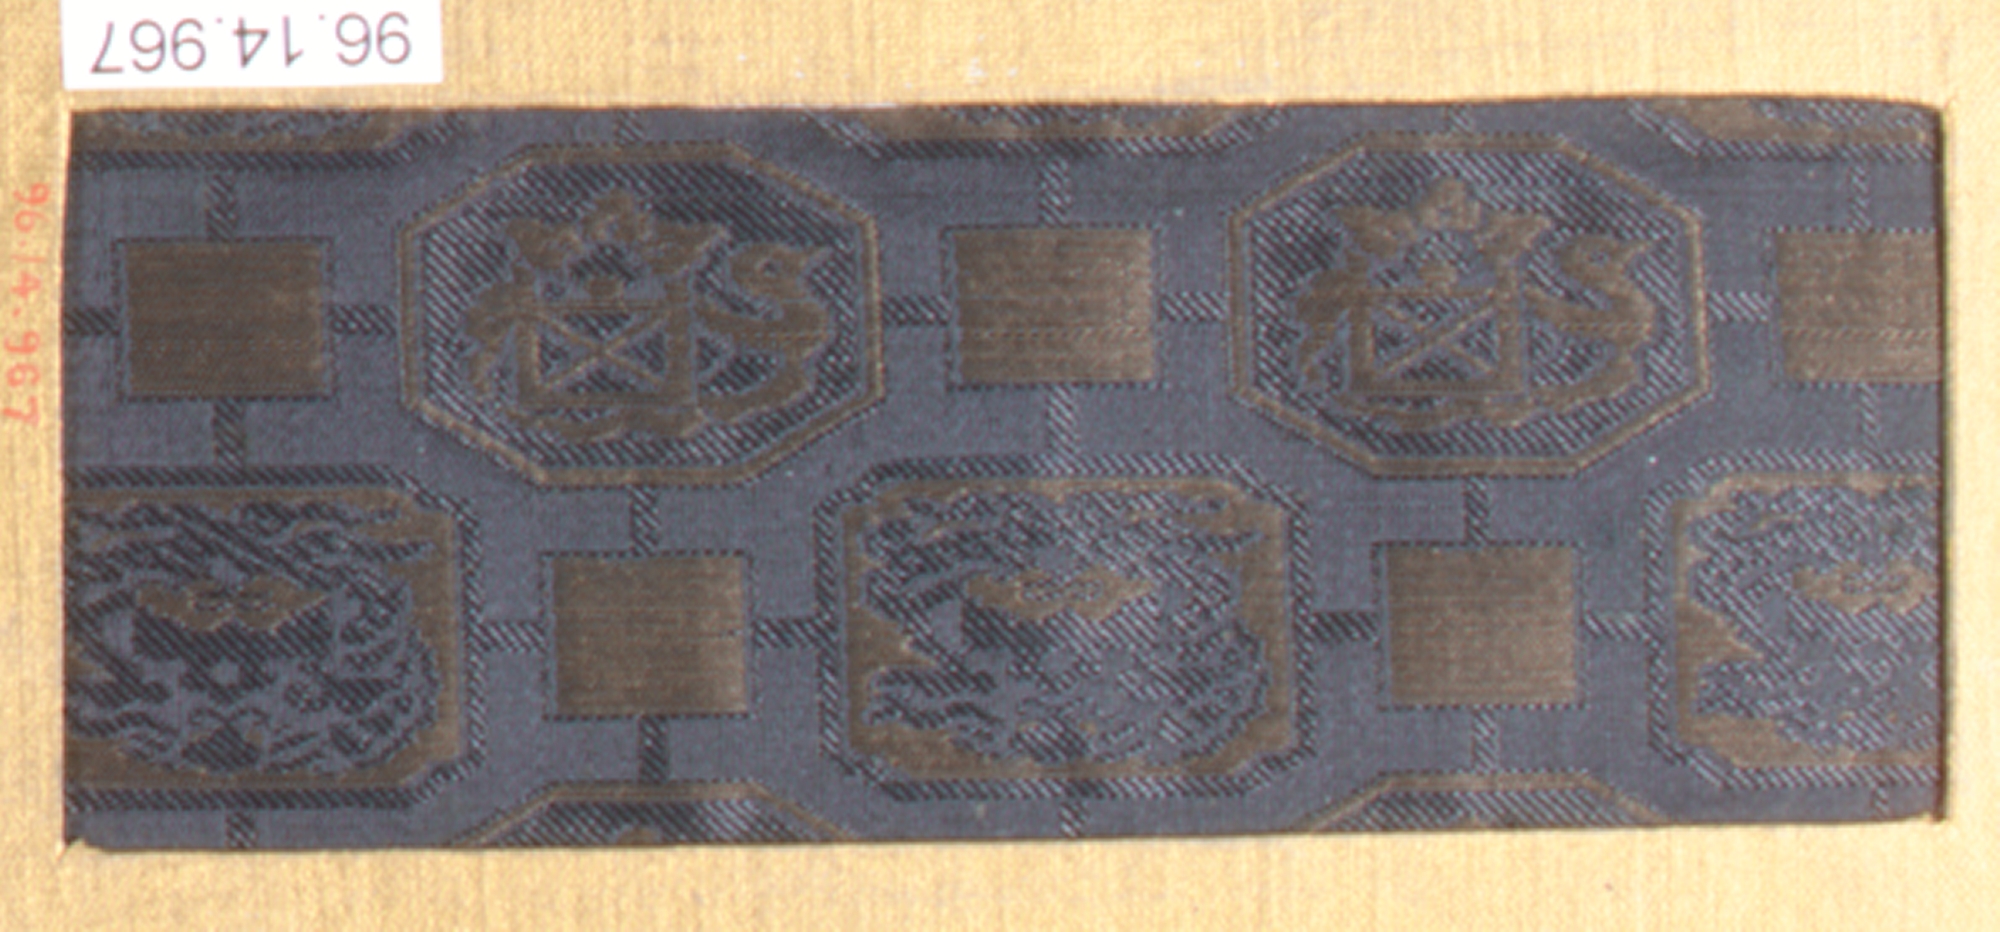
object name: piece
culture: japanese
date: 1701-1900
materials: silk